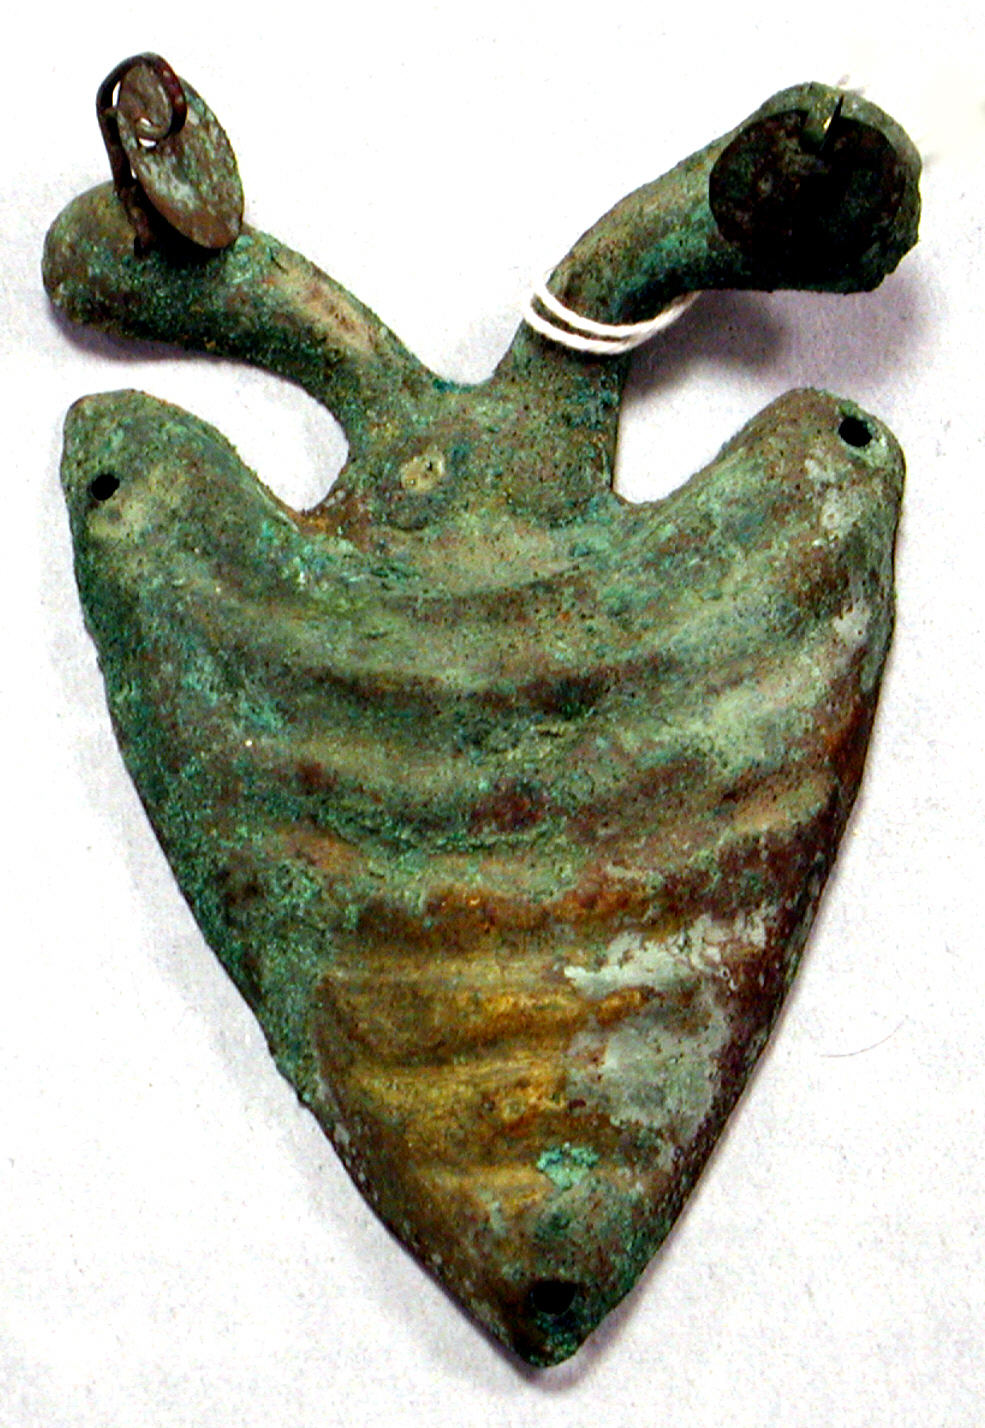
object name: ornament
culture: moche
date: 501-700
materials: gilt copper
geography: peru